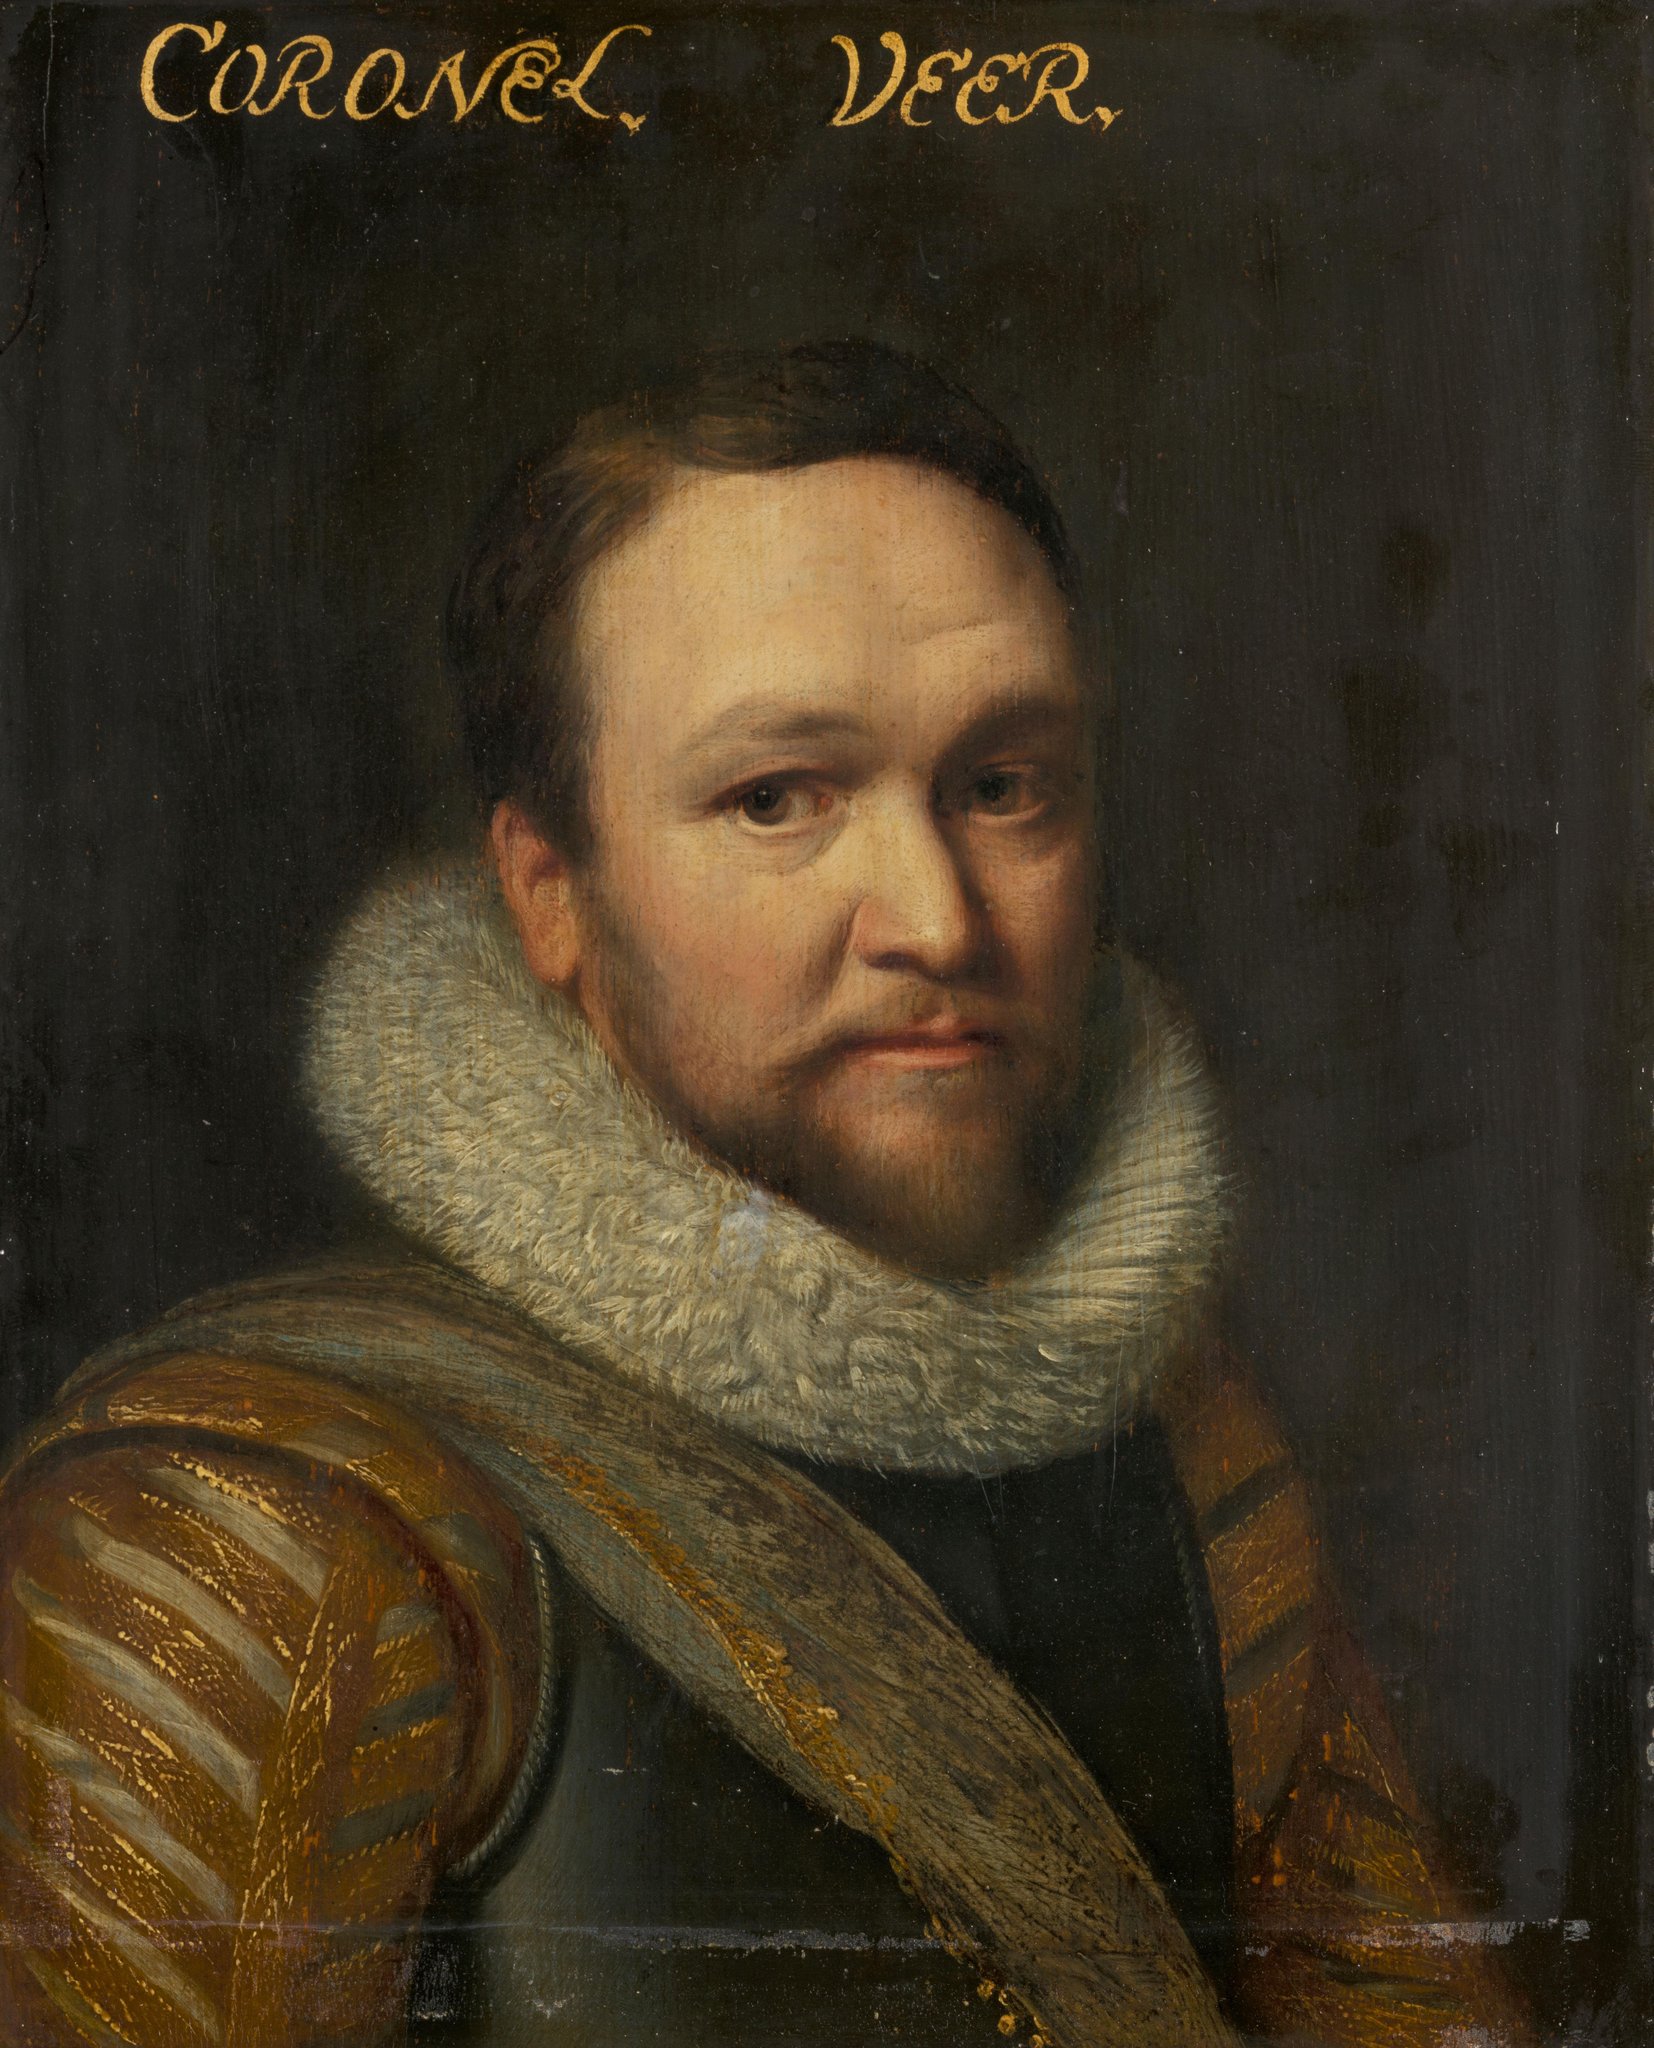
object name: painting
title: Portrait of Sir Horace Vere (1565-1635)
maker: michiel jansz van mierevelt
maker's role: draughtsman, painter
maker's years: 1567-1641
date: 1615-1633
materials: oil, panel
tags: historical persons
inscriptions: inscription, top: ‘CORONEL. VEER.’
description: Sir Horace Vere, later Lord Vere of Tilbury (1565-1635,) naar M.J. van Miereveld.